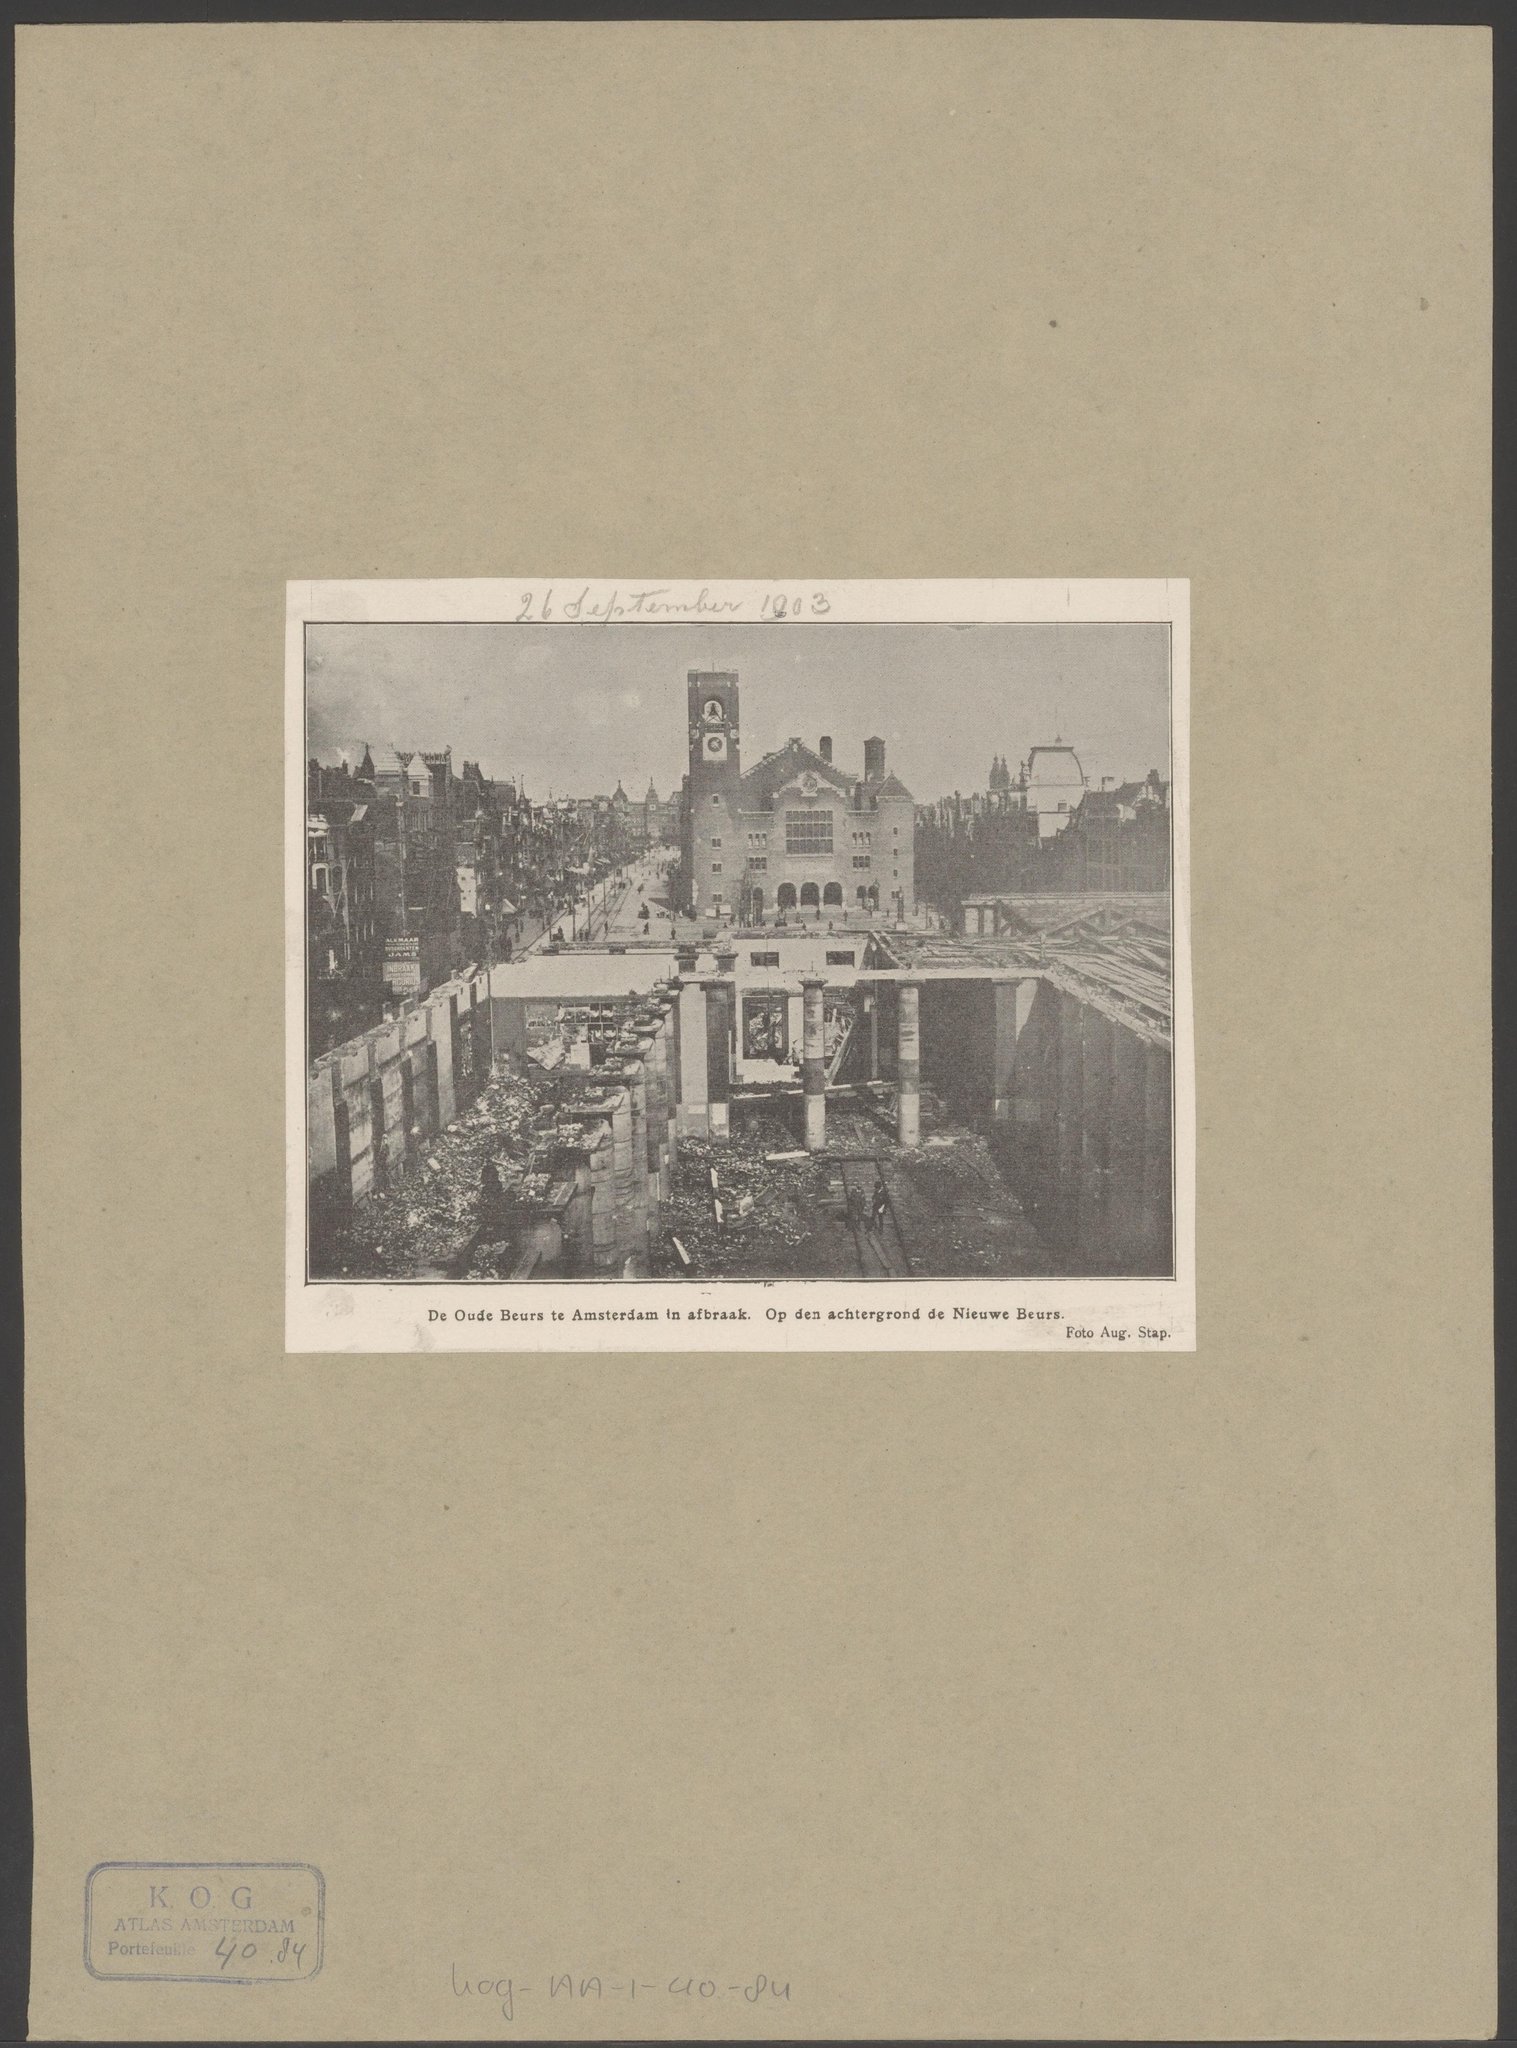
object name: photomechanical print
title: Gezicht op de Beurs van Berlage en de afbraak van de Beurs van Zocher te Amsterdam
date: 1903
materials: paper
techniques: letterpress printing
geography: netherlands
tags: stock exchange, stock-market, demolition of building, street (+ city(-scape) with figures, staffage)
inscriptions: collector's mark: Lugt 1641b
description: Onderwerpsrubriek binnen de Atlas Amsterdam: Handel en Zeevaart: Hulpbeurs op de Dam en Beurs (Dam).